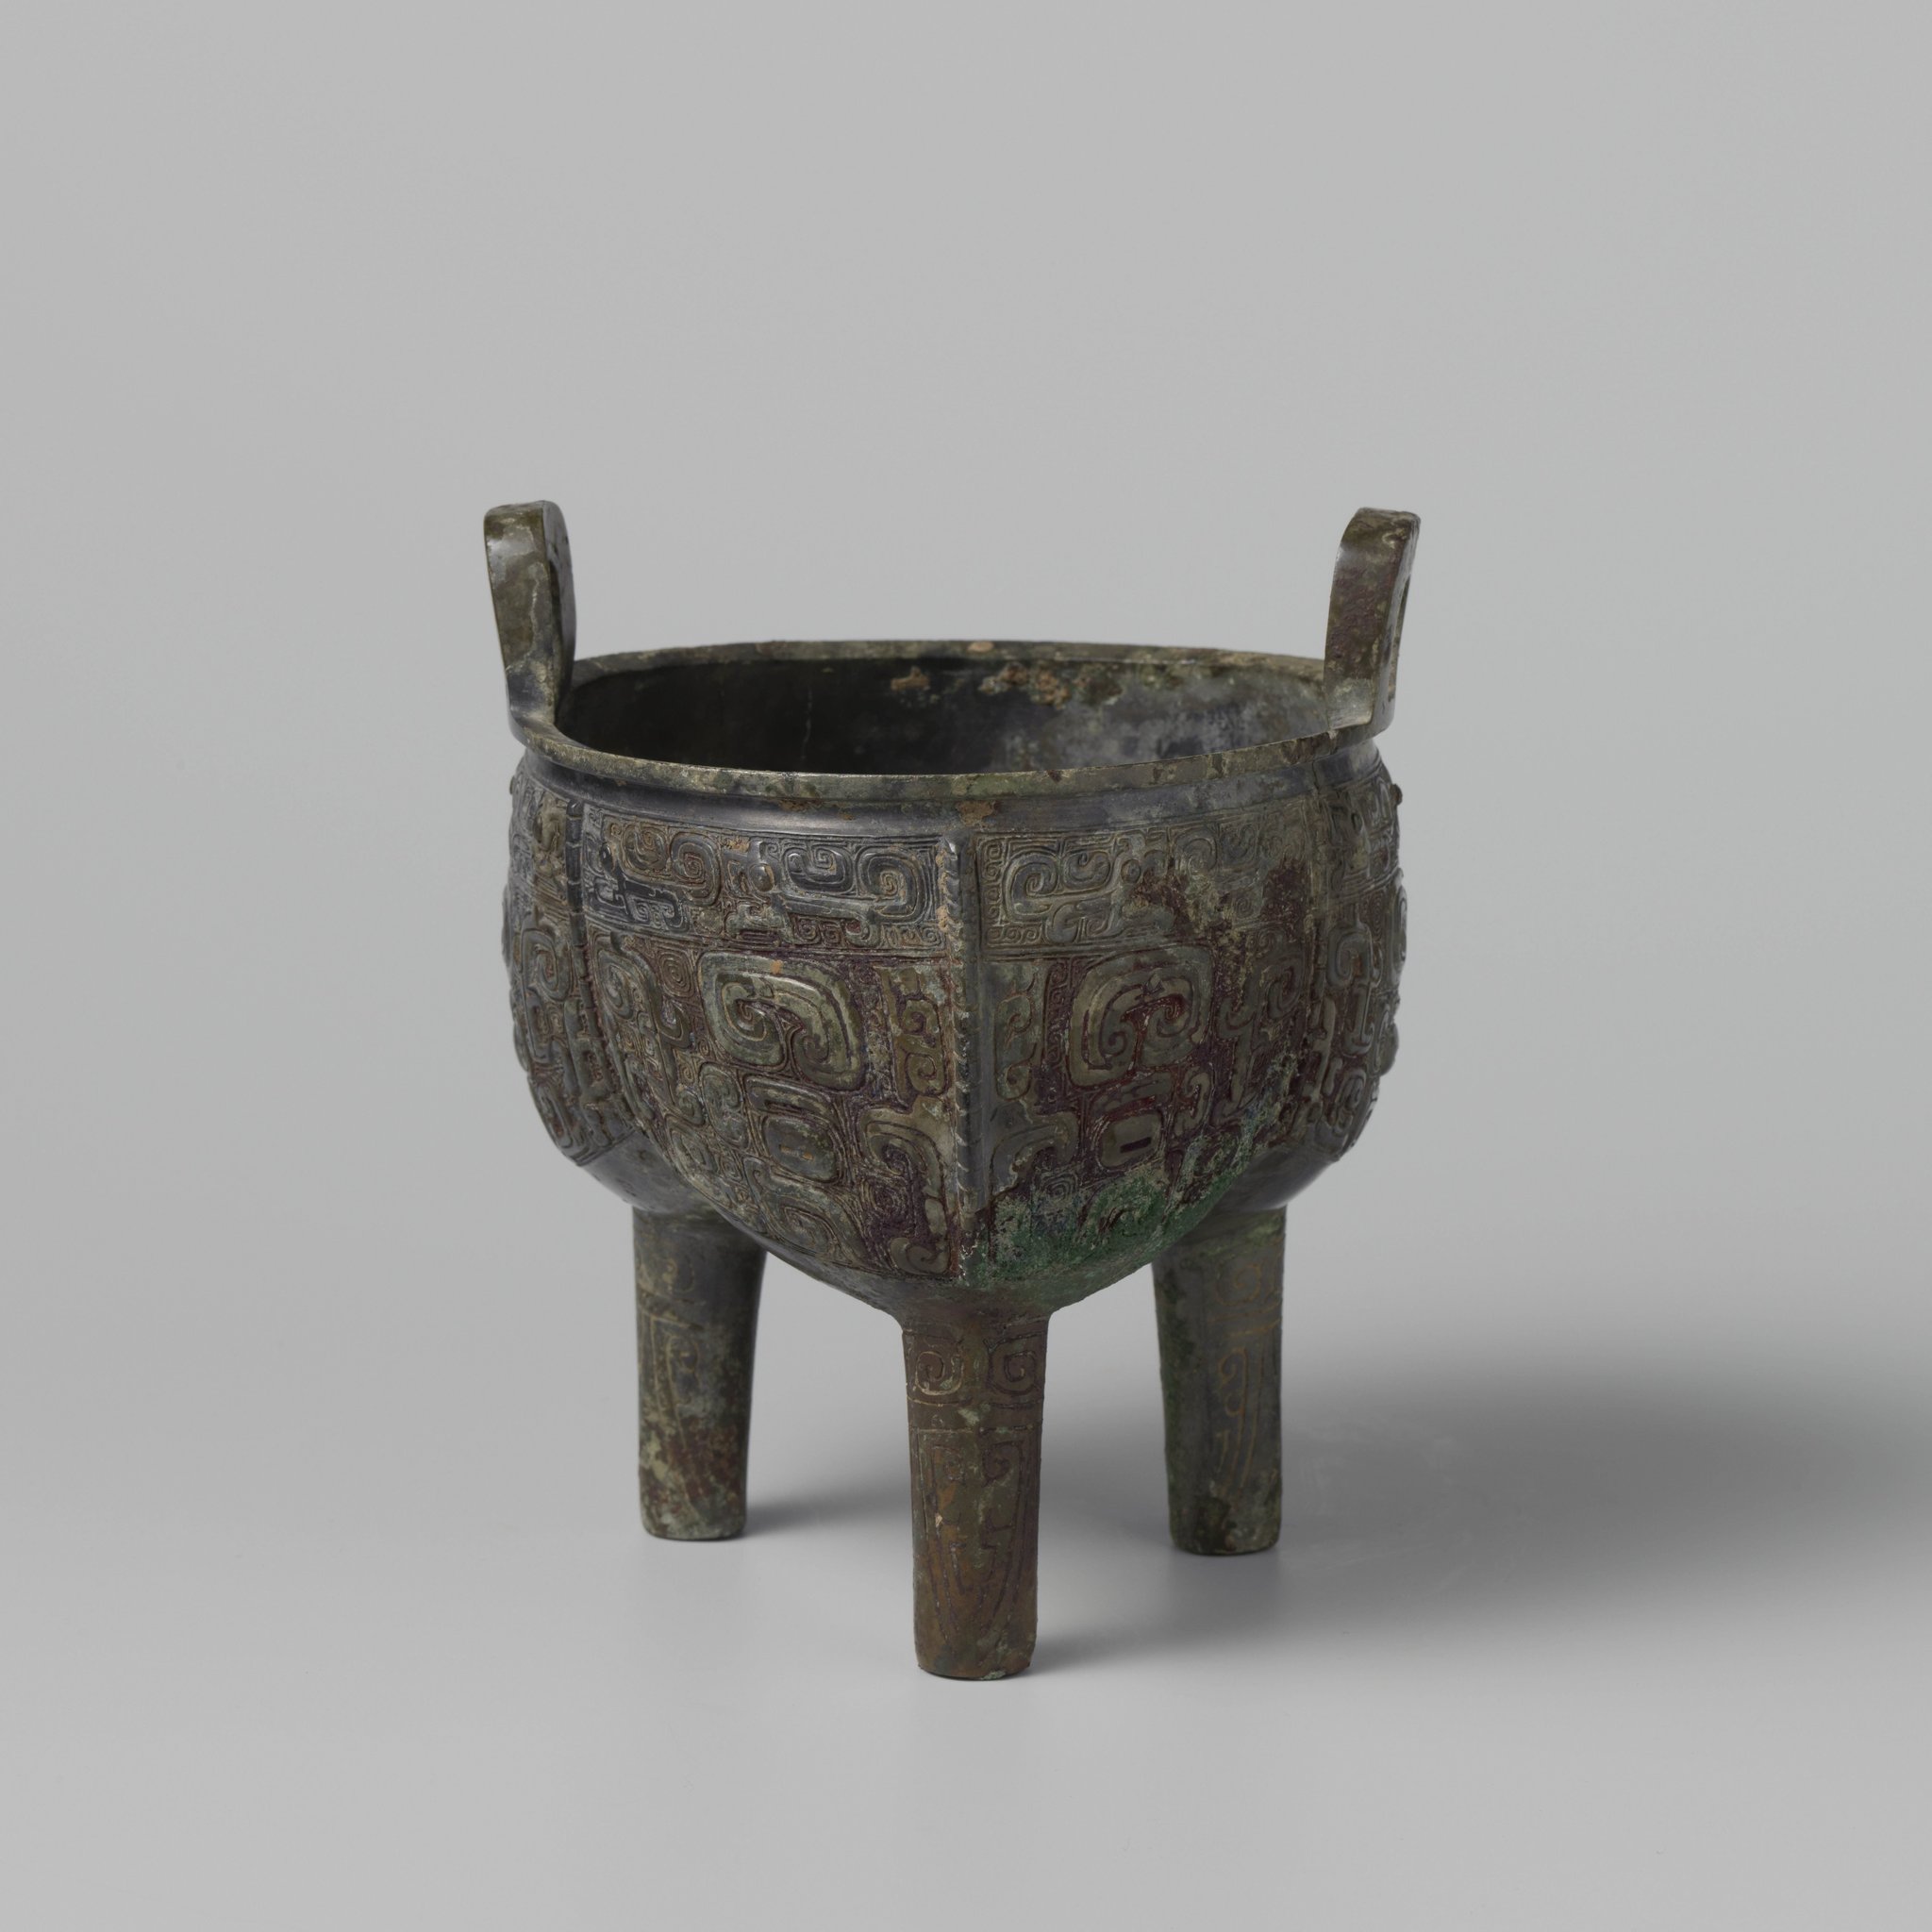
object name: liding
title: Ritual food vessel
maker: Anonymous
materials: bronze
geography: china